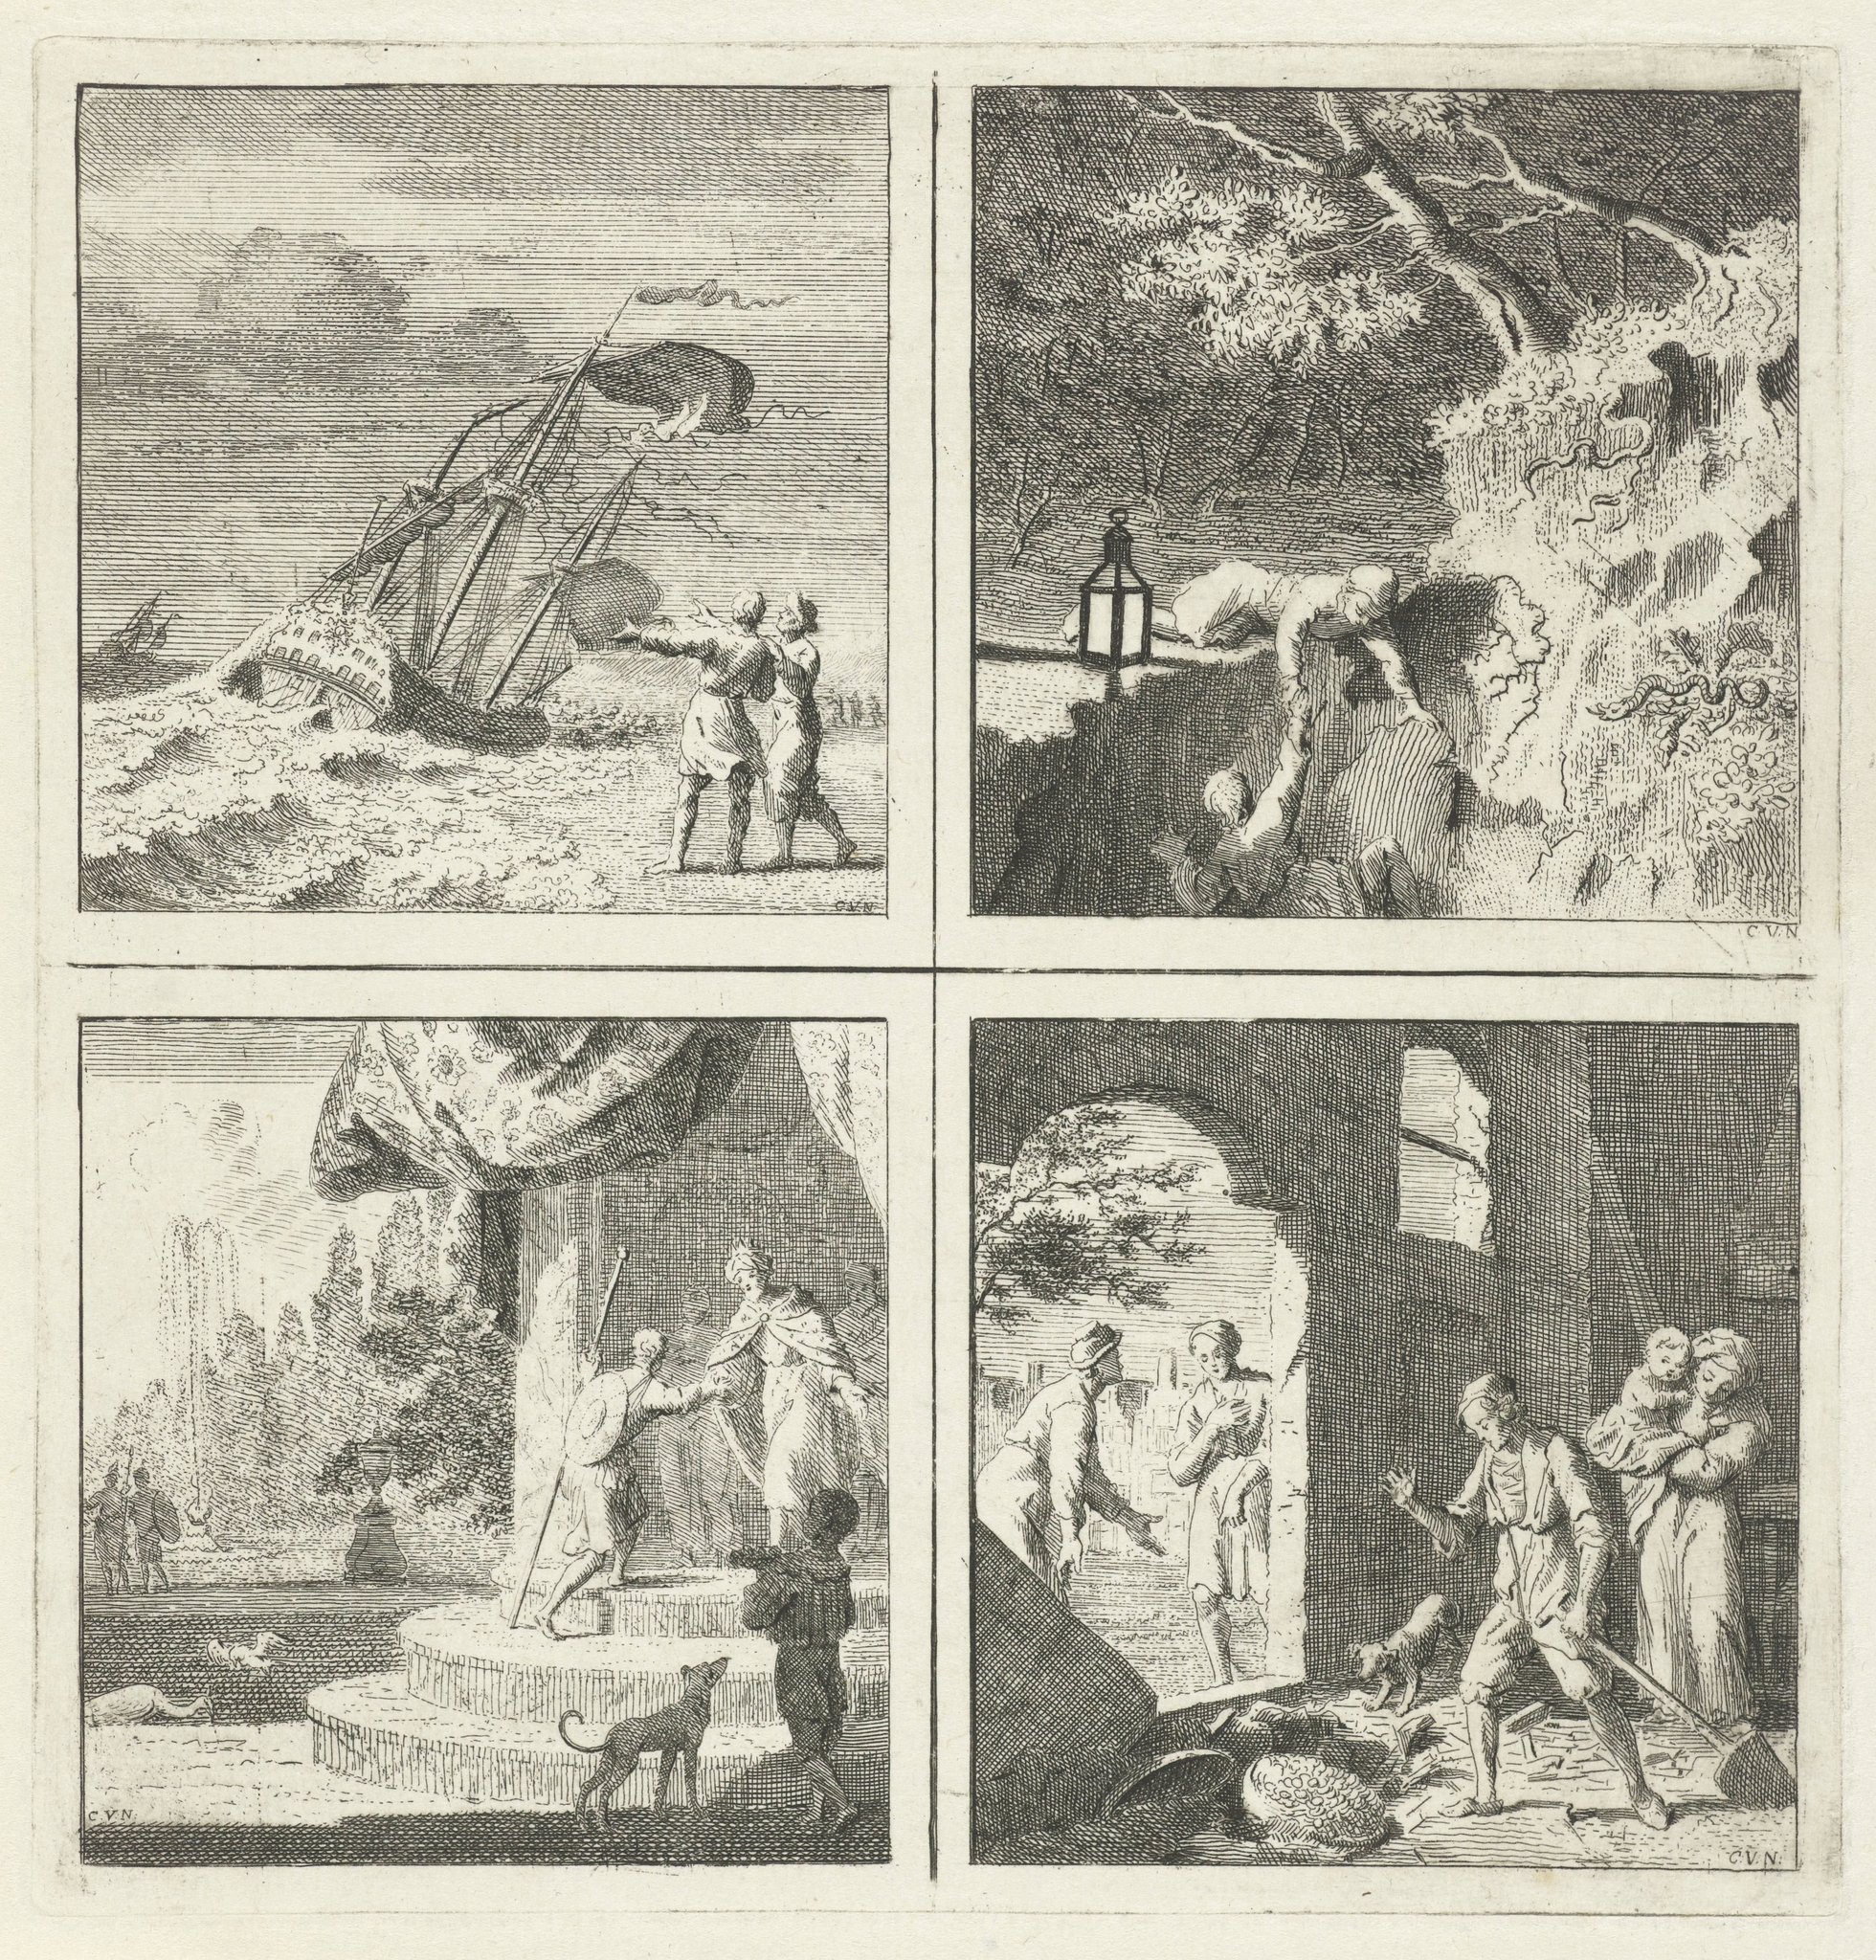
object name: print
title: Zeegezicht / Twee figuren bij een afgrond / Koning ontvangt zijn gast / Vinden van een schat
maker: cornelis van noorde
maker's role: draughtsman, print maker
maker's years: 1731-1795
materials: paper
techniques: etching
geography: haarlem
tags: canopy, baldachin, shipwreck, ravine, chasm, abyss, canyon, lantern, ruler, sovereign, digging for or finding of treasure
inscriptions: collector's mark: Lugt 240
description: Vier voorstellingen. Linksboven: een zeilschip voor de kust in moeilijkheden. Twee mannen op het strand kijken toe. Op zee vaart een ander schip. Afbeelding bij een tekst, waarin gesteld wordt dat een schip op het strand een baken op zee is. Daarmee wordt opgeroepen om uit alles wat men ziet te leren. Rechtsboven: een jongen helpt een andere jongen uit de afgrond klimmen. Op de rand staat een lantaarn. Linksonder: een koning ontvangt onder een baldakijn een bezoeker, die een staf in de hand heeft en een hoed op de rug. Rechtsonder: het interieur van een vervallen huis, waarin een man met een schop een schat vindt. Achter hem staat een vrouw met een kind op de arm. In de opening staan twee andere mensen.